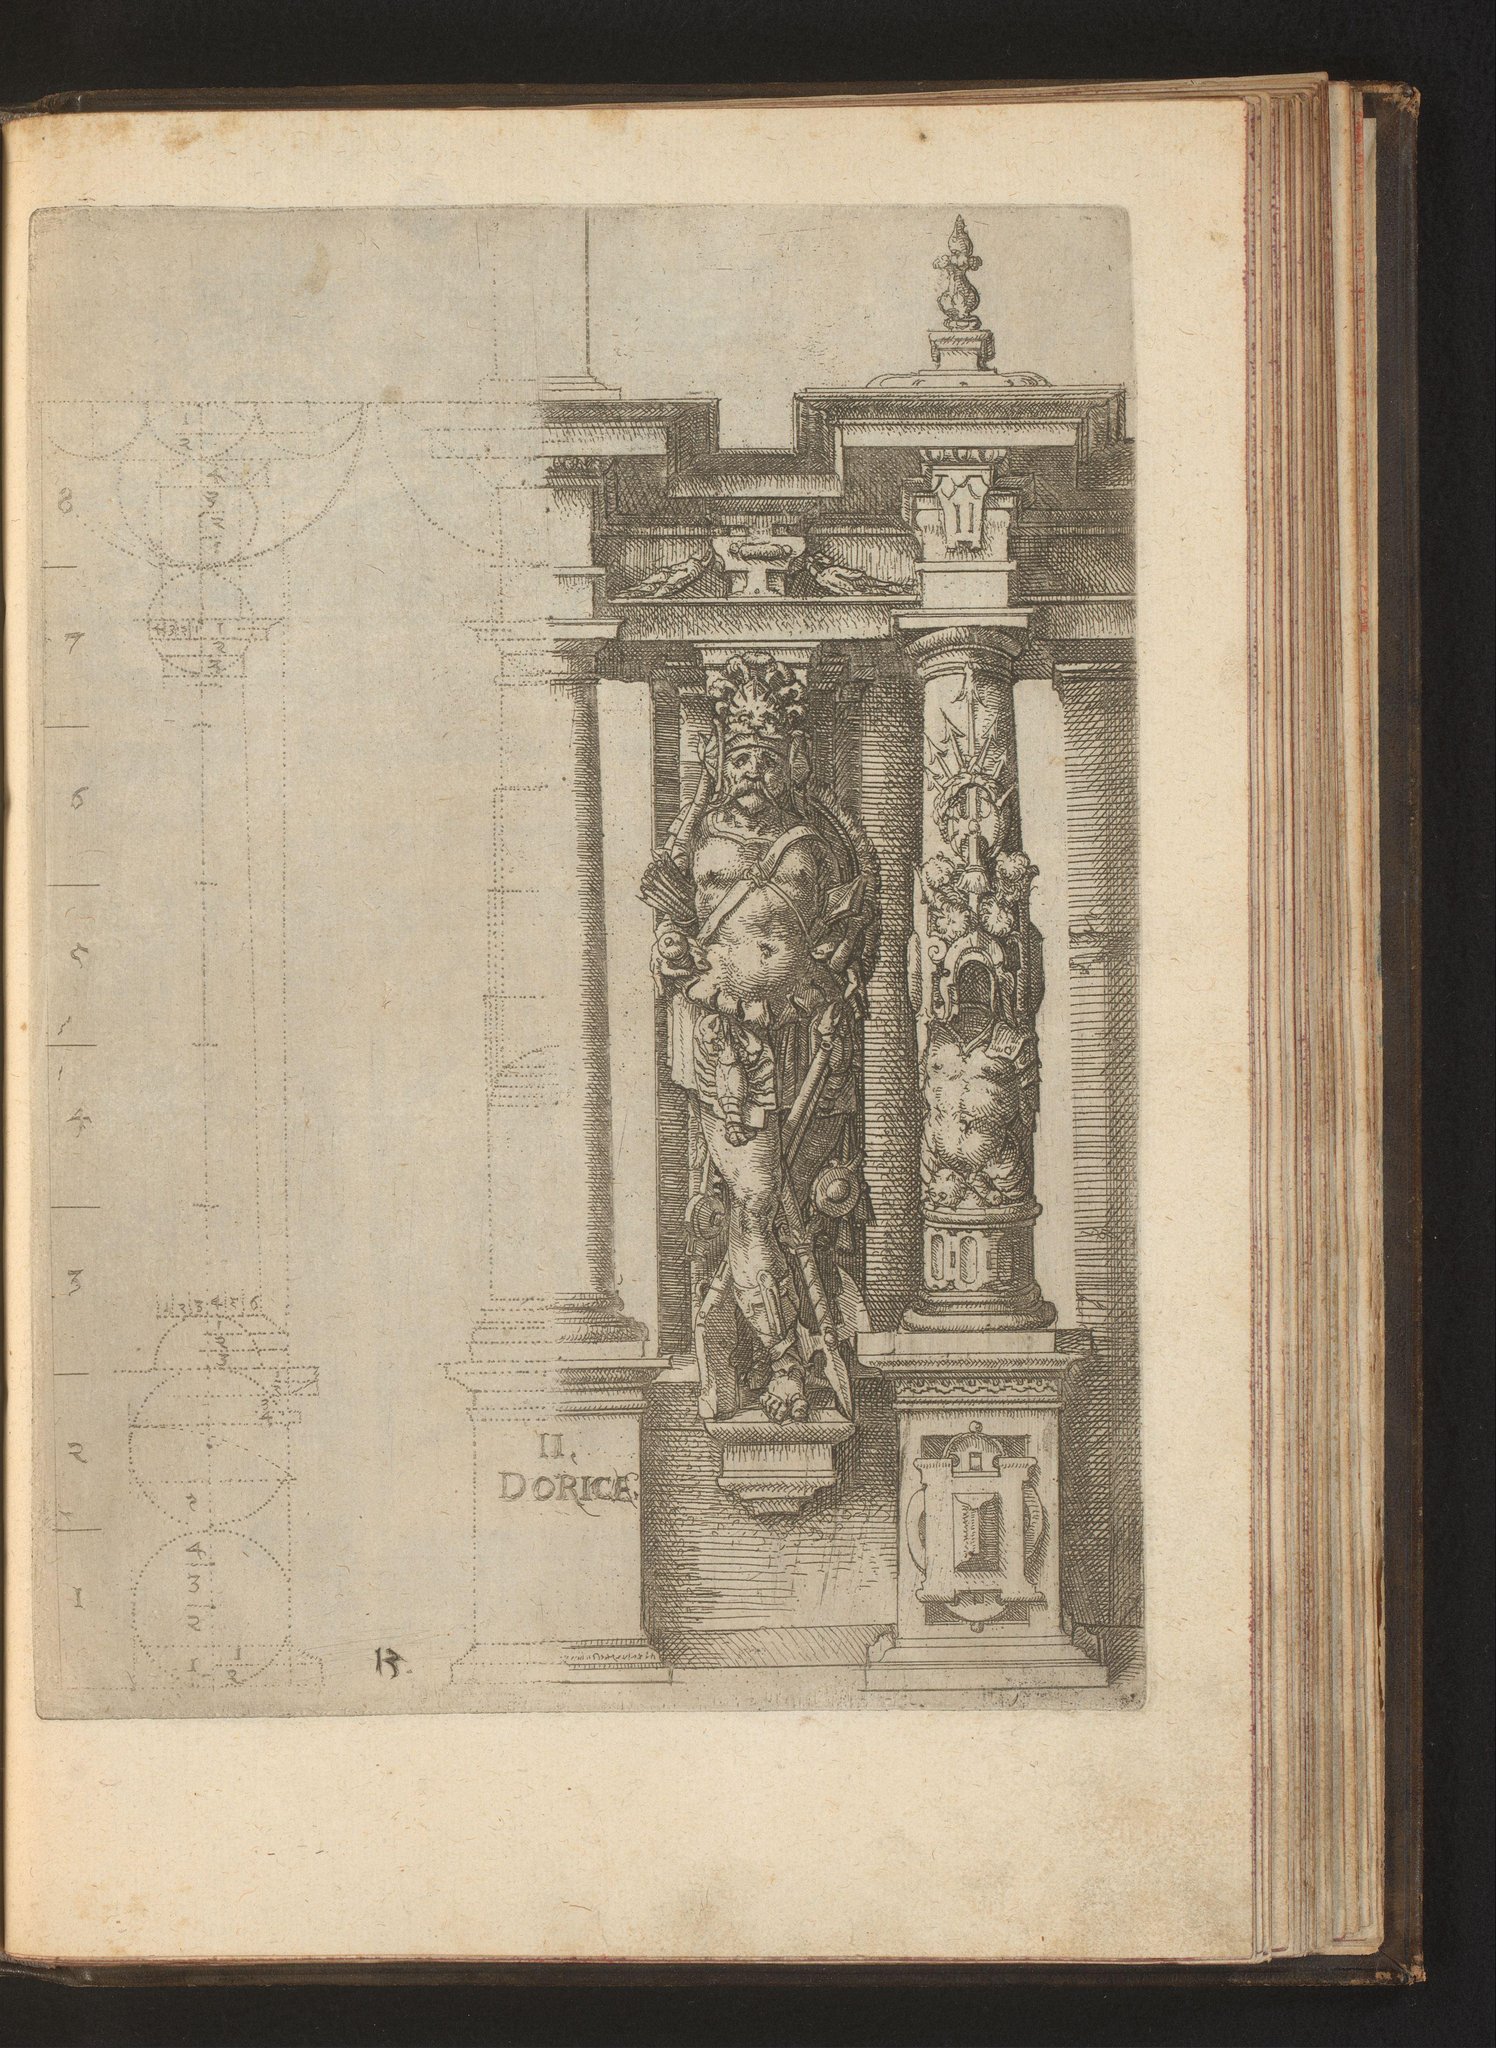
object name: page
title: Architectura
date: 1593-1595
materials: paper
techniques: etching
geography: straatsburg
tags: atlantes ~ architecture, column, pillar ~ architecture, doric order ~ architecture, pedestal of a piece of sculpture (perhaps in the form of a herm) (+ architecture)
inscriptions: collector's mark: Lugt 2228, collector's mark: Lugt 2760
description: Prent gebruikt in: Dietterlin, Wendel (I). Wendel Dietterlin, Architectura de Polstium seu Portalium ornatu uario Liber II. Straatsburg: Bernhard Jobin, 1594.